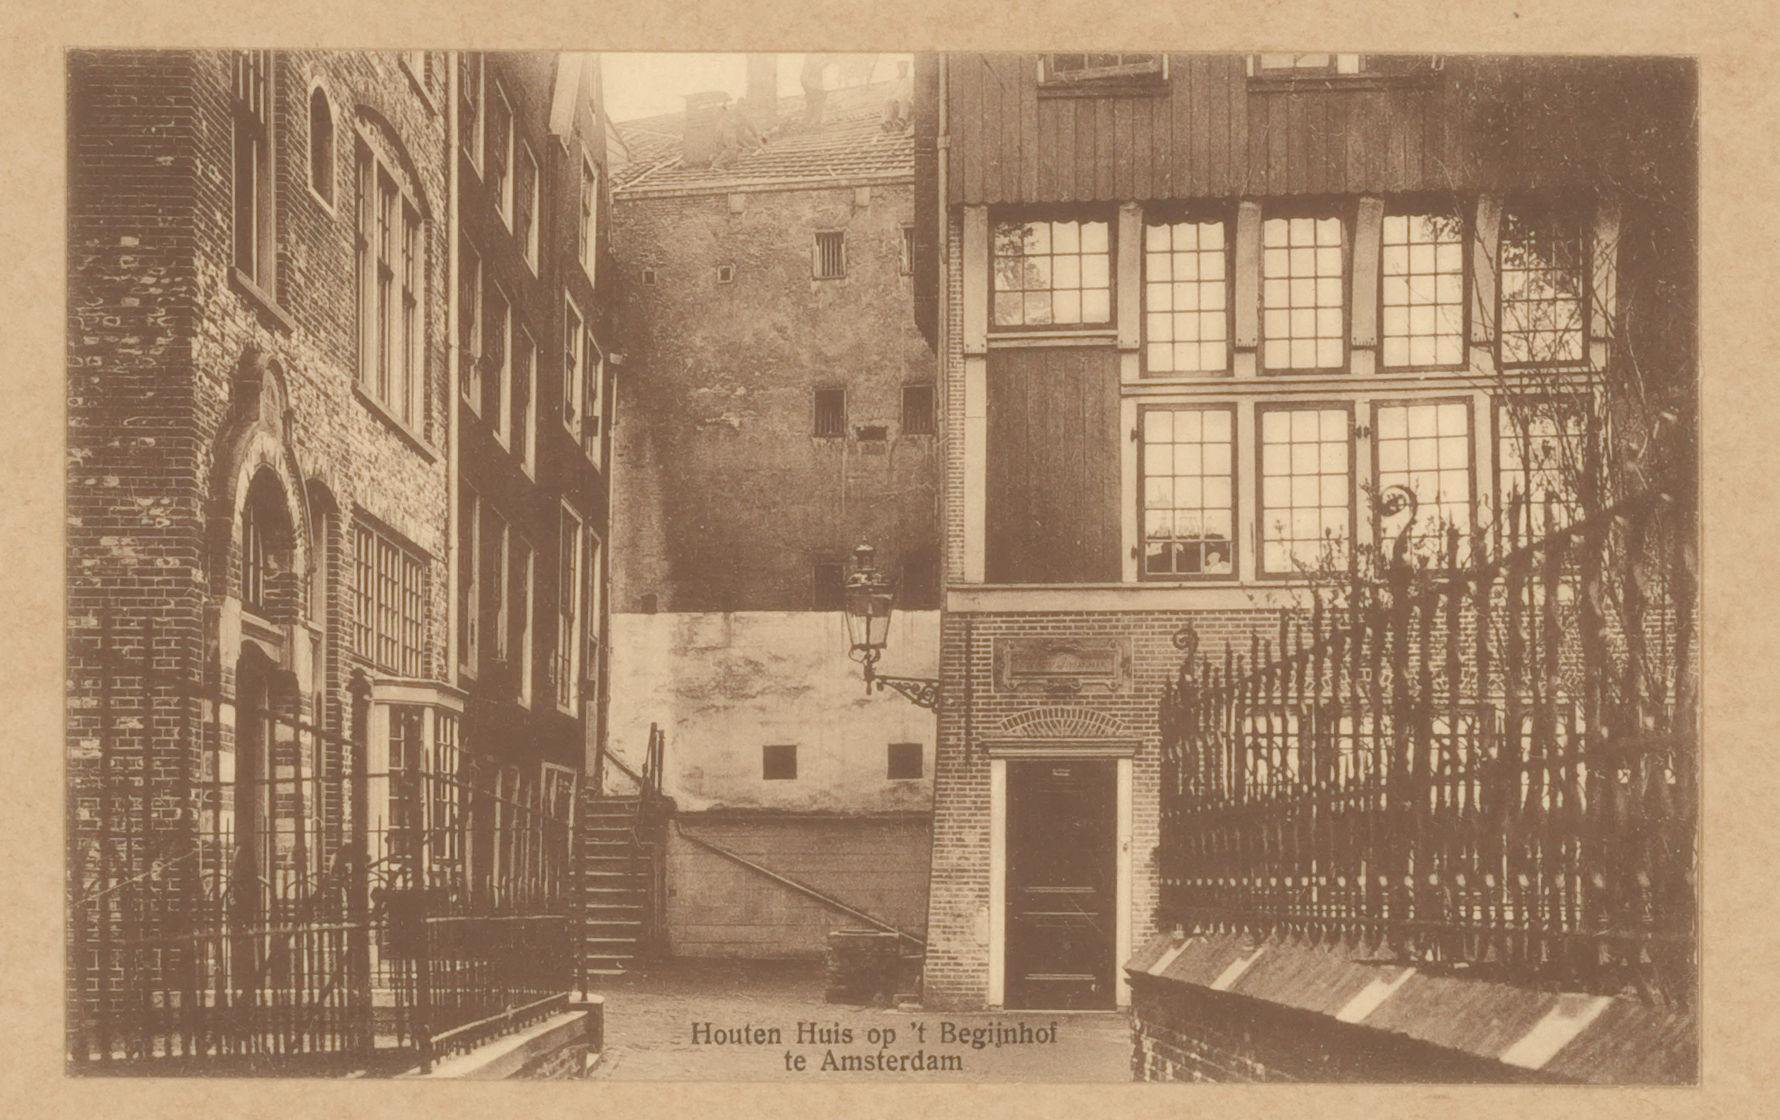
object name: photomechanical print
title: Houten Huis op 't Begijnhof te Amsterdam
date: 1907-1919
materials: paper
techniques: photograph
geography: amsterdam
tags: civic architecture; edifices; dwellings, street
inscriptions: collector's mark: Lugt 1641b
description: Onderwerpsrubriek binnen de Atlas Amsterdam: Kerkwezen: R.K. Gemeenten: Begijnhof t/m Petrus en Paulus.